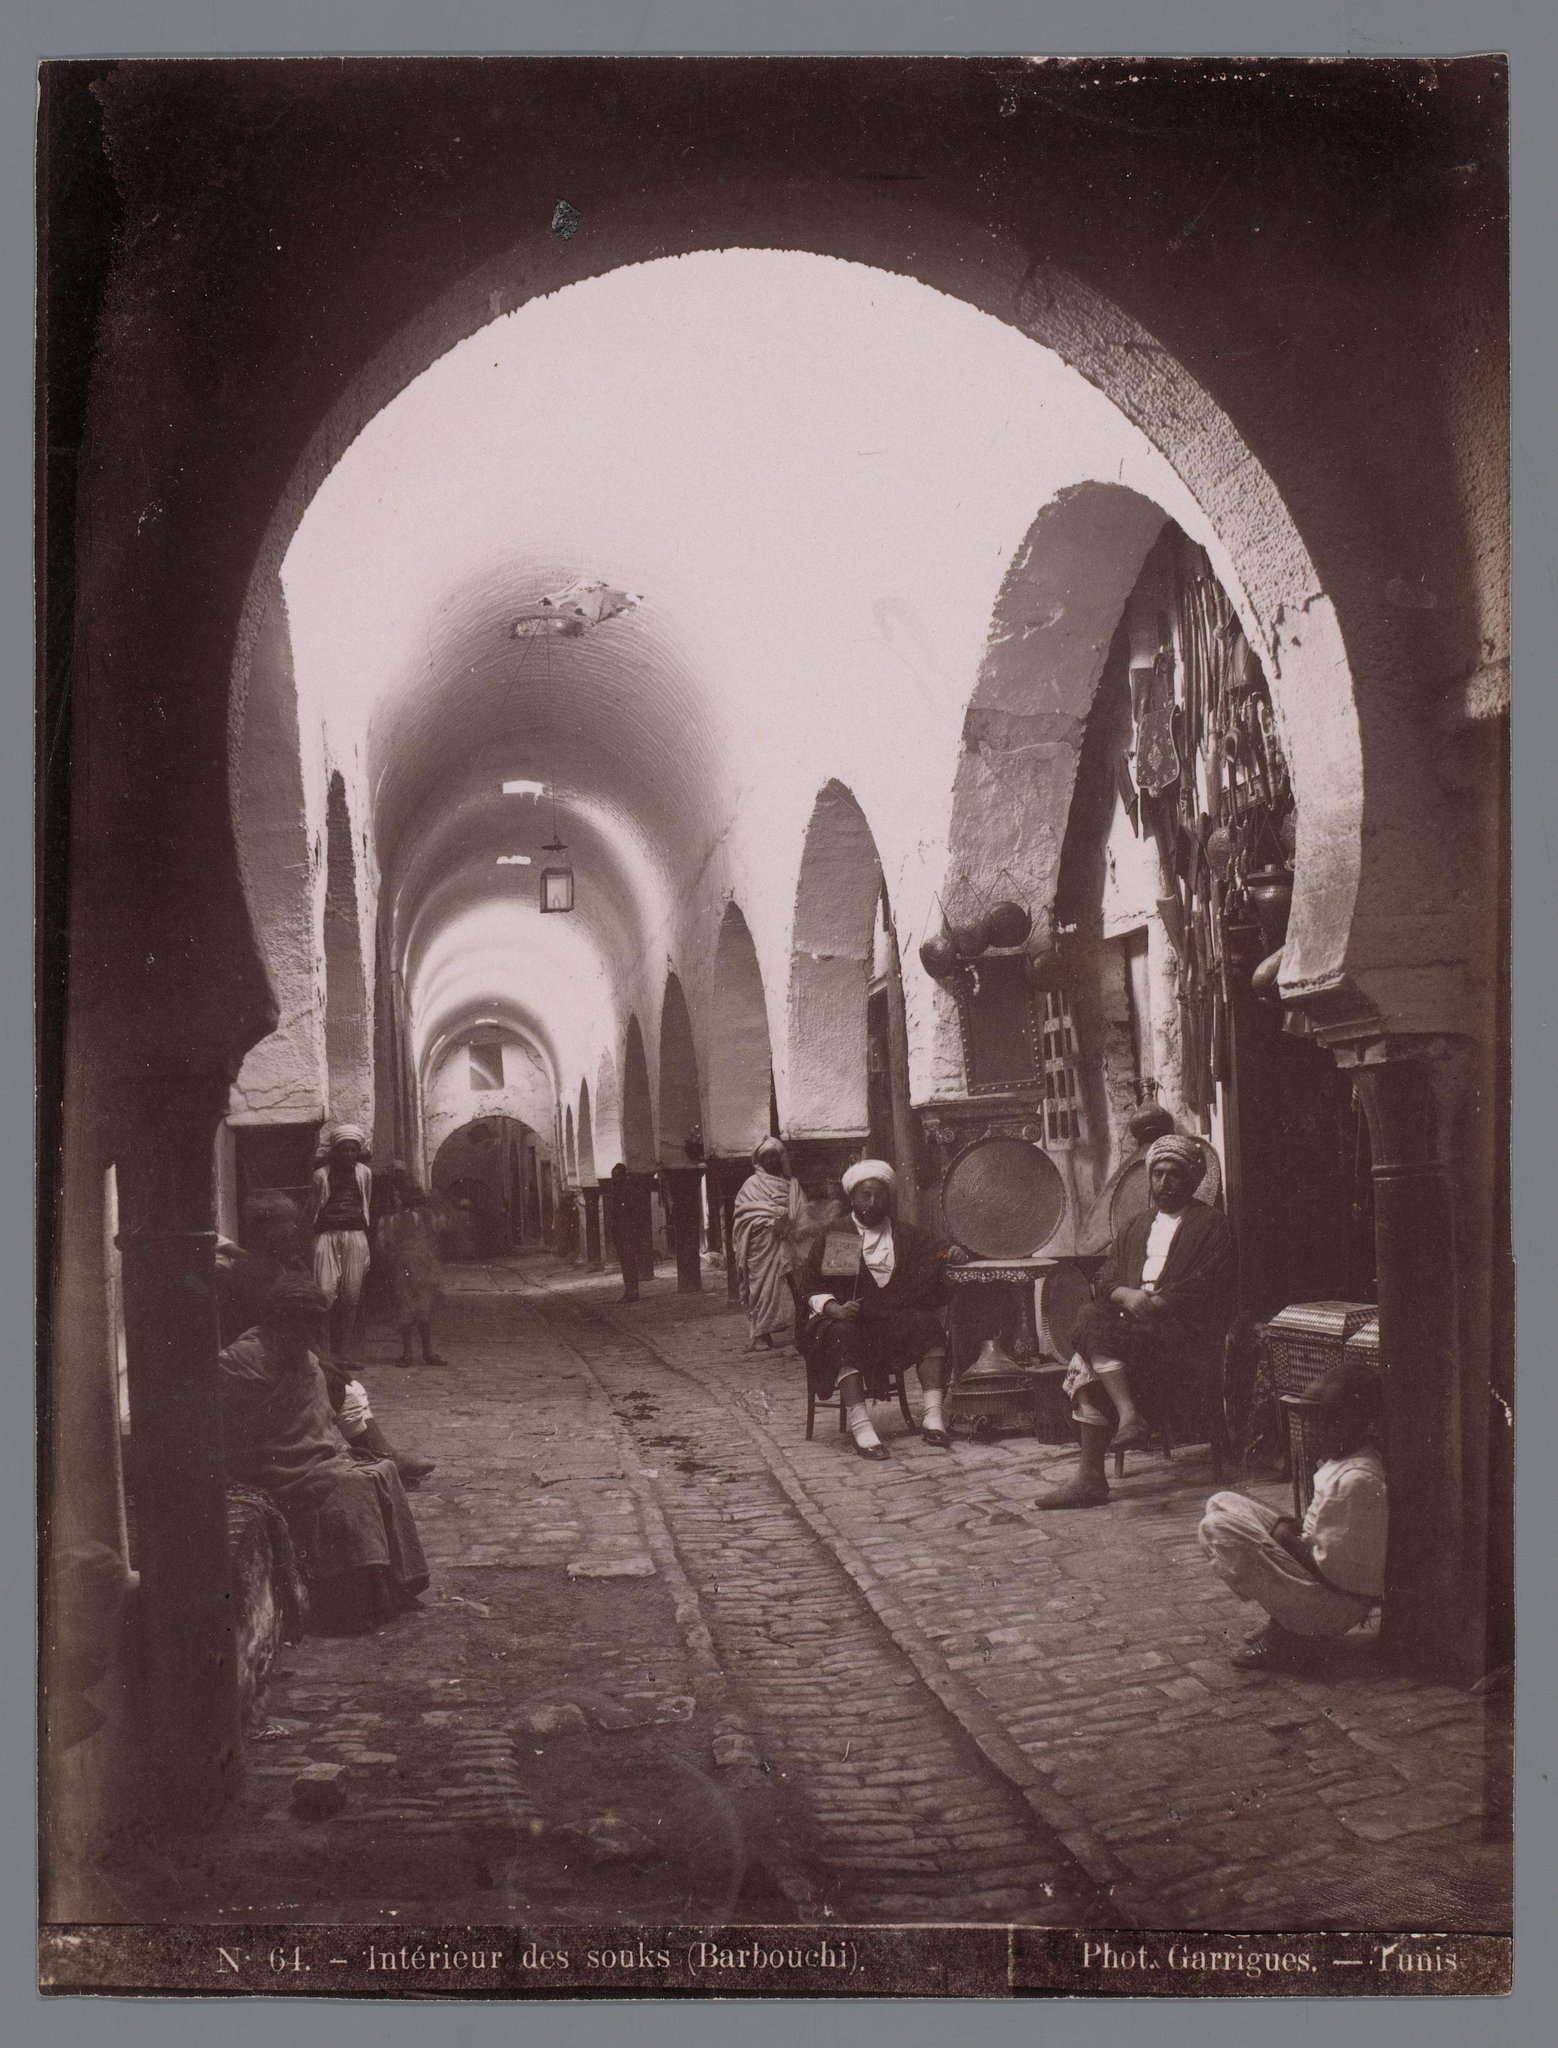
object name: photograph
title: Gezicht in de Souk el-Trouk in de Medina van Tunis, rechts de winkel van de Barbouchi Frères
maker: j. andré garrigues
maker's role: fotograaf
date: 1860-1900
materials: paper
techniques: albumen print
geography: medina of tunis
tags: market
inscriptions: number: ‘N. 64.’